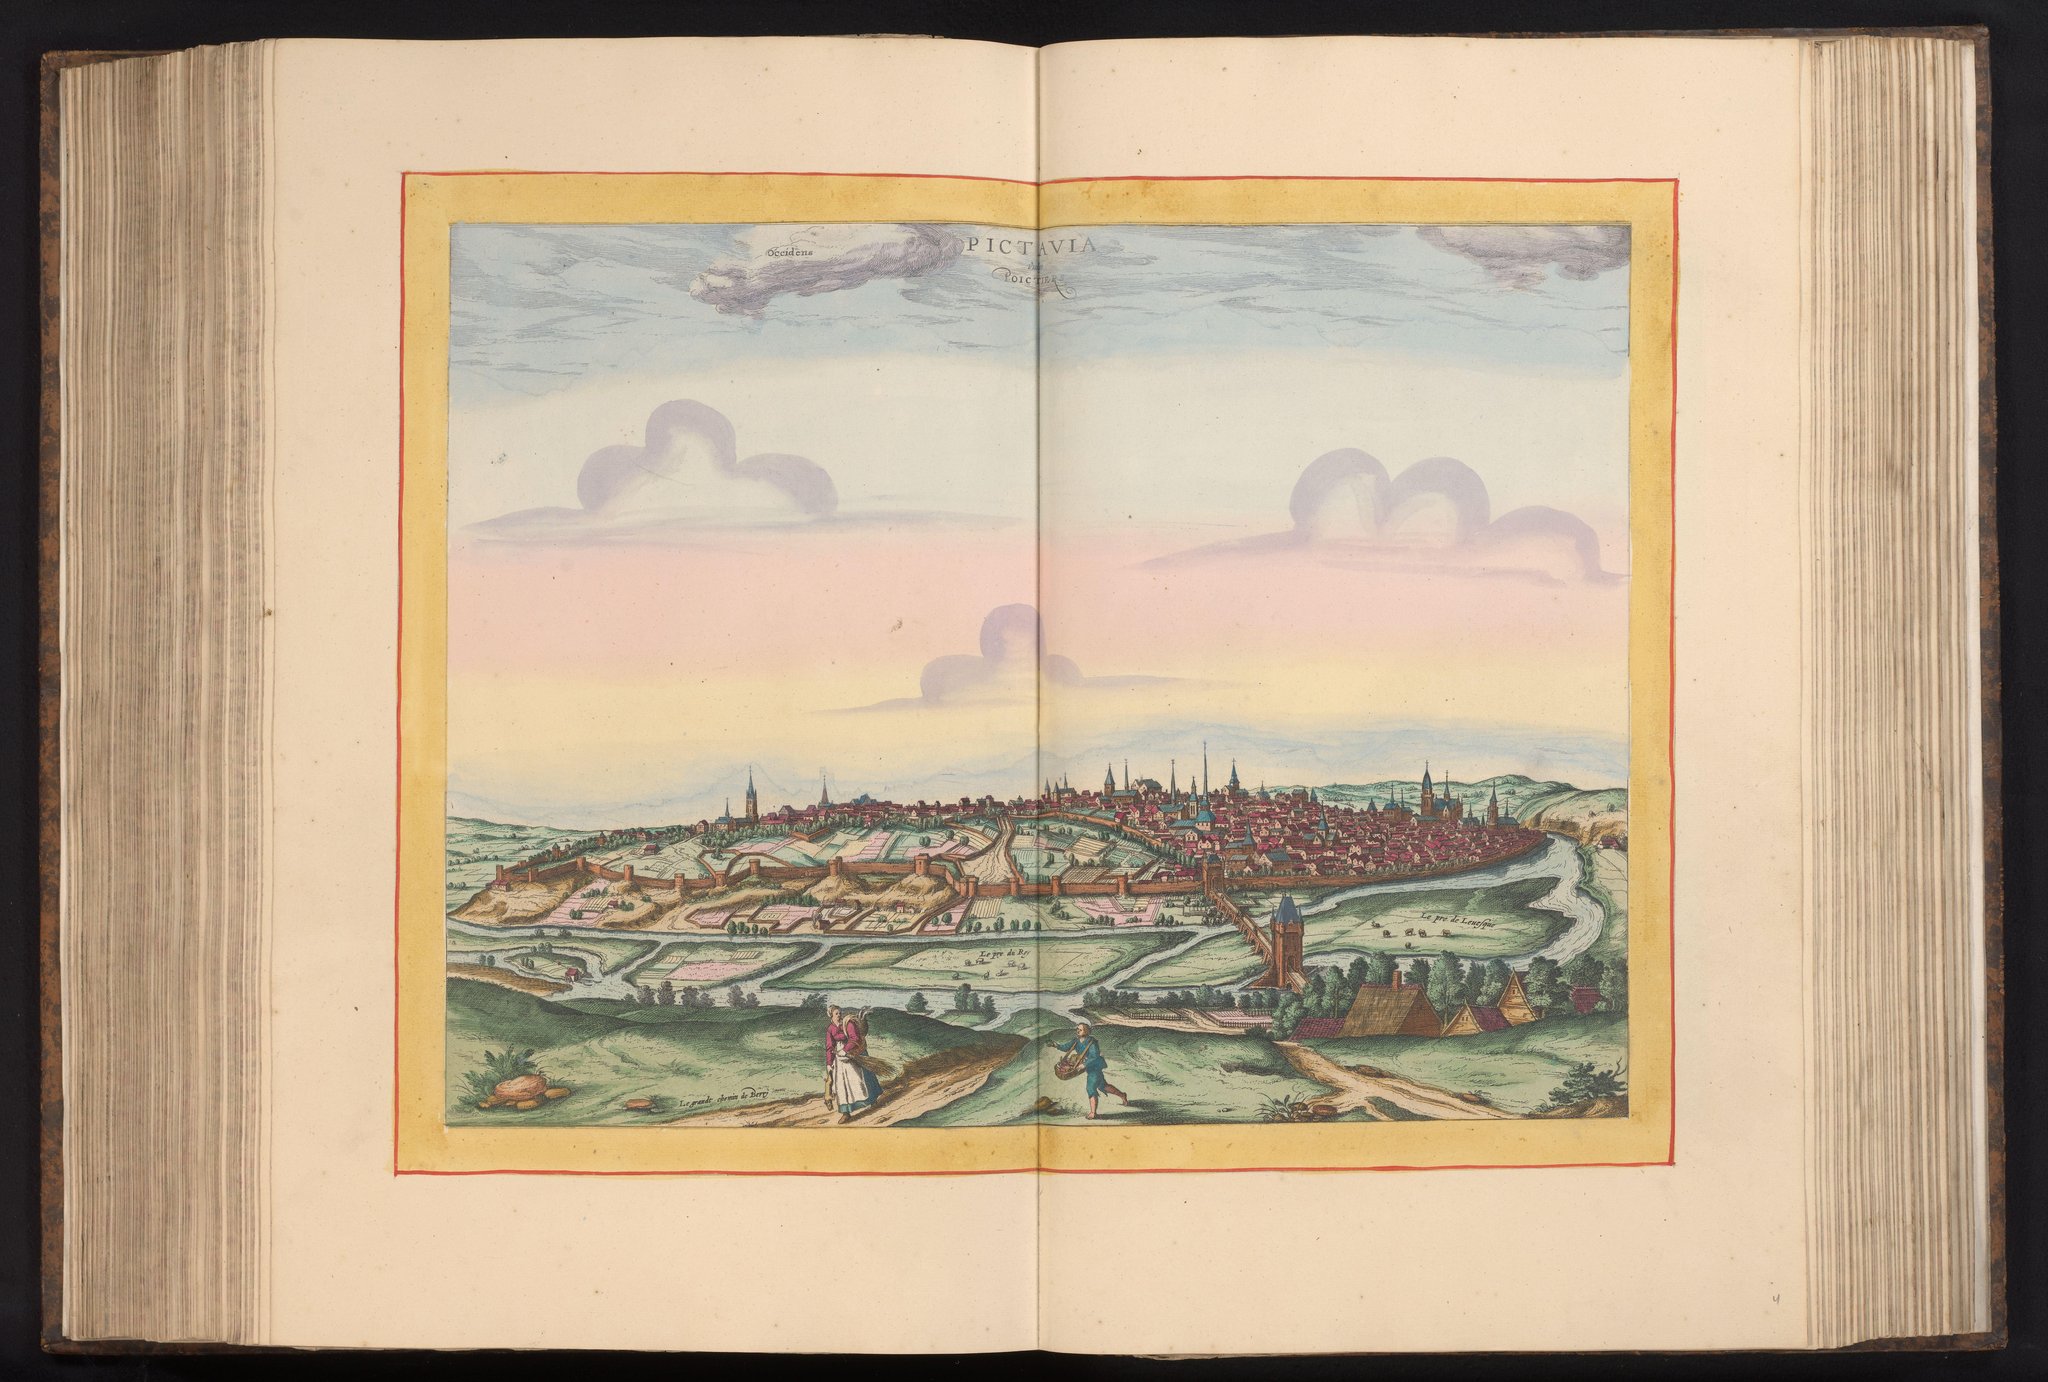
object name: album leaf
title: Gezicht op Poitiers in vogelvluchtperspectief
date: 1596-1682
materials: paper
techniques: engraving, etching, hand coloring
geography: the hague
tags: city-view in general; 'veduta'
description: Deze prent is in een aantal atlassen gebruikt. Onder andere in: Braun, Georg & Franz Hogenberg. Civitates orbis terrarum. S.l.s.n., 1596-1597, en in: Theatrum exhibens celebriores Galliae et Helvetae urbes. Amsterdam: Johannes Janssonius, 1657, en in: Tooneel der vermaarste koop-steden. Amsterdam: erven Johannes Janssonius van Waesberge, 1682. Deze prent is origineel gedrukt van één plaat met een gezicht op Henrichemont en een afbeelding van een rotsblok nabij Poitiers (RP-P-1956-219).